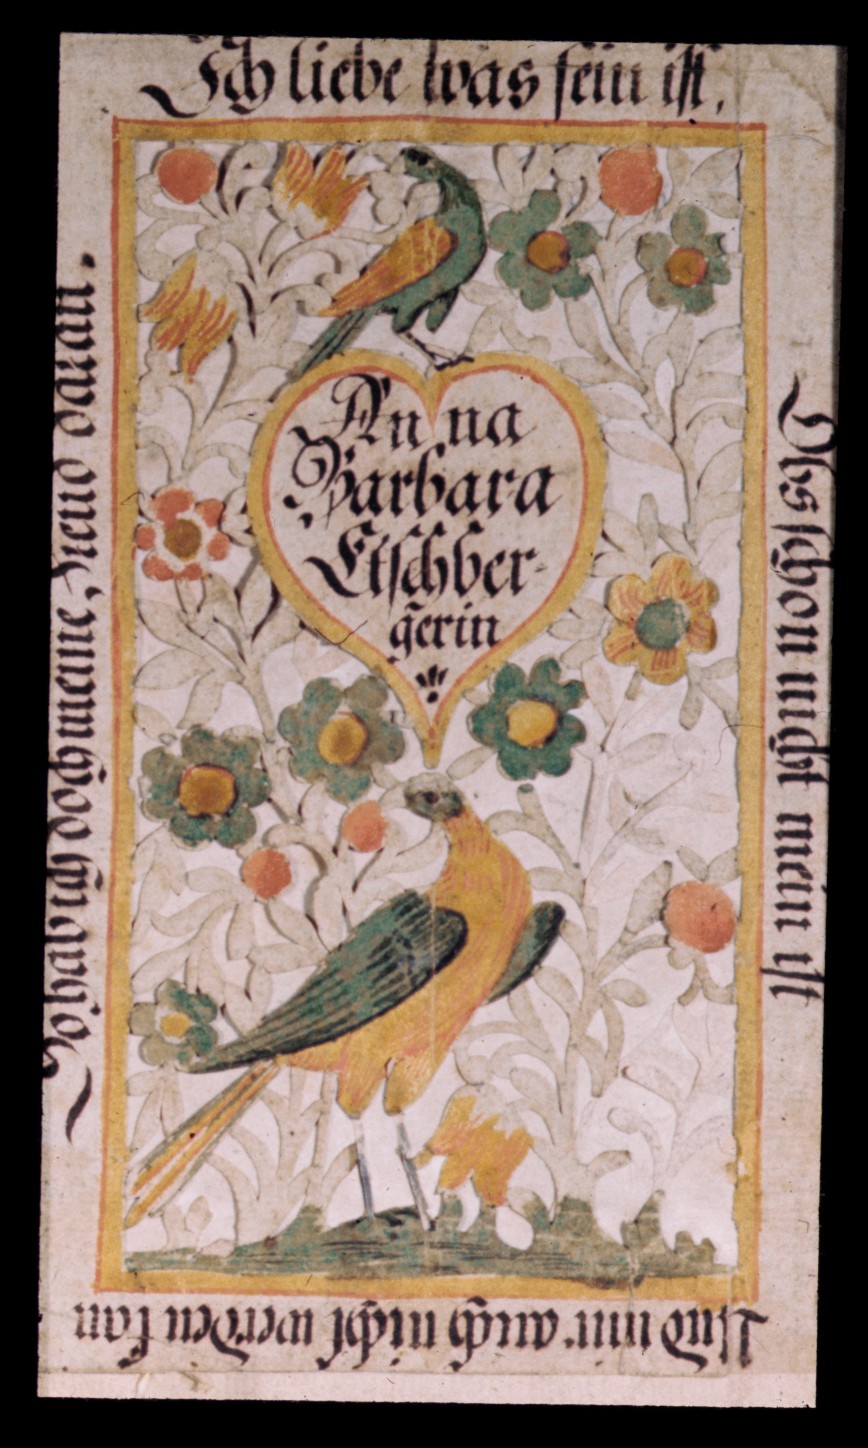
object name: love token, fraktur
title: Love Token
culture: american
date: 1800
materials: ink, paper, watercolor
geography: united states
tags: birds,flowers